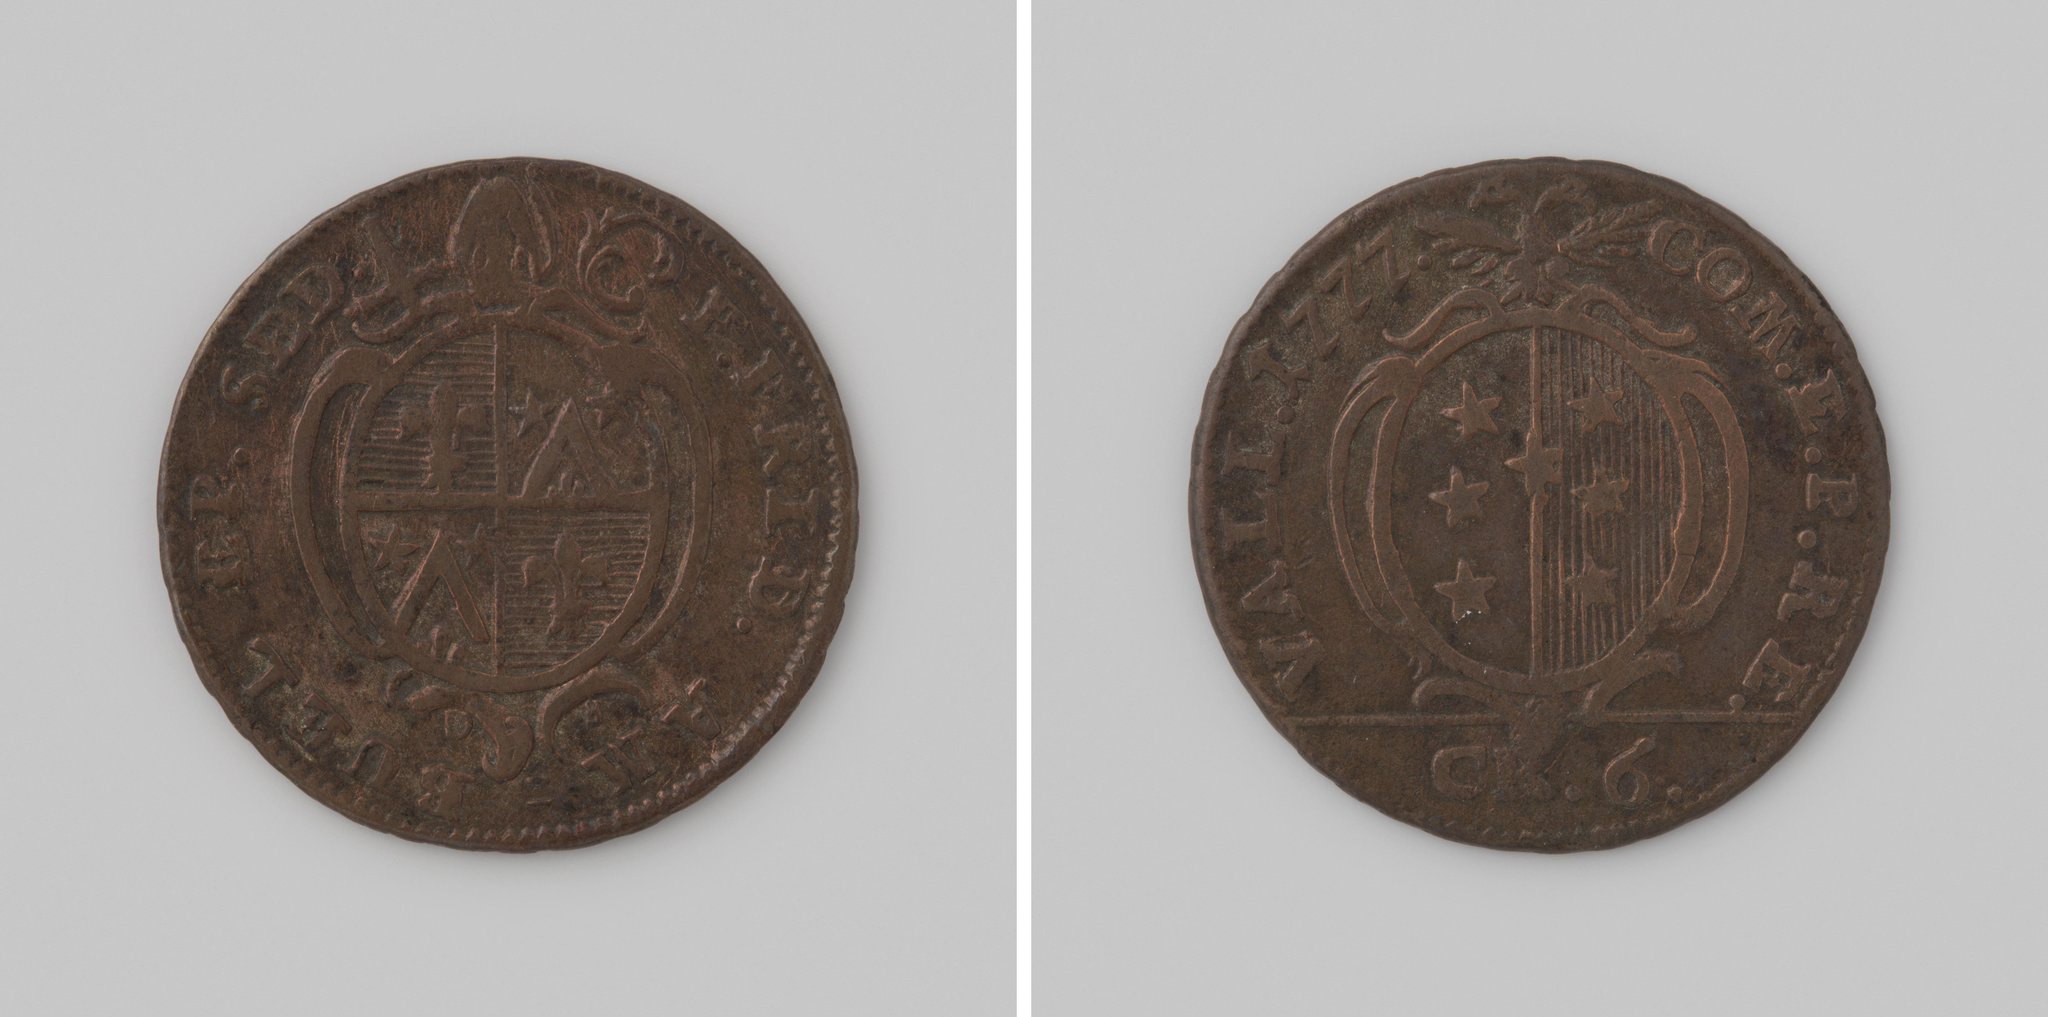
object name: coin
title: Bisdom Sitten (Sion), Franz Friedrich, 6 Creuzer, 1777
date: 1777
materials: copper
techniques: striking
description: Koperen munt. Voorzijde: samengesteld ovaal wapenschild, waaromheen attributen van de bisschop. Keerzijde: versierd wapenschild, waarboven adelaar. In afsnede waarde-aanduiding: CR. 6. Jaartal aan het eind van het omschrift. Gladde rand.